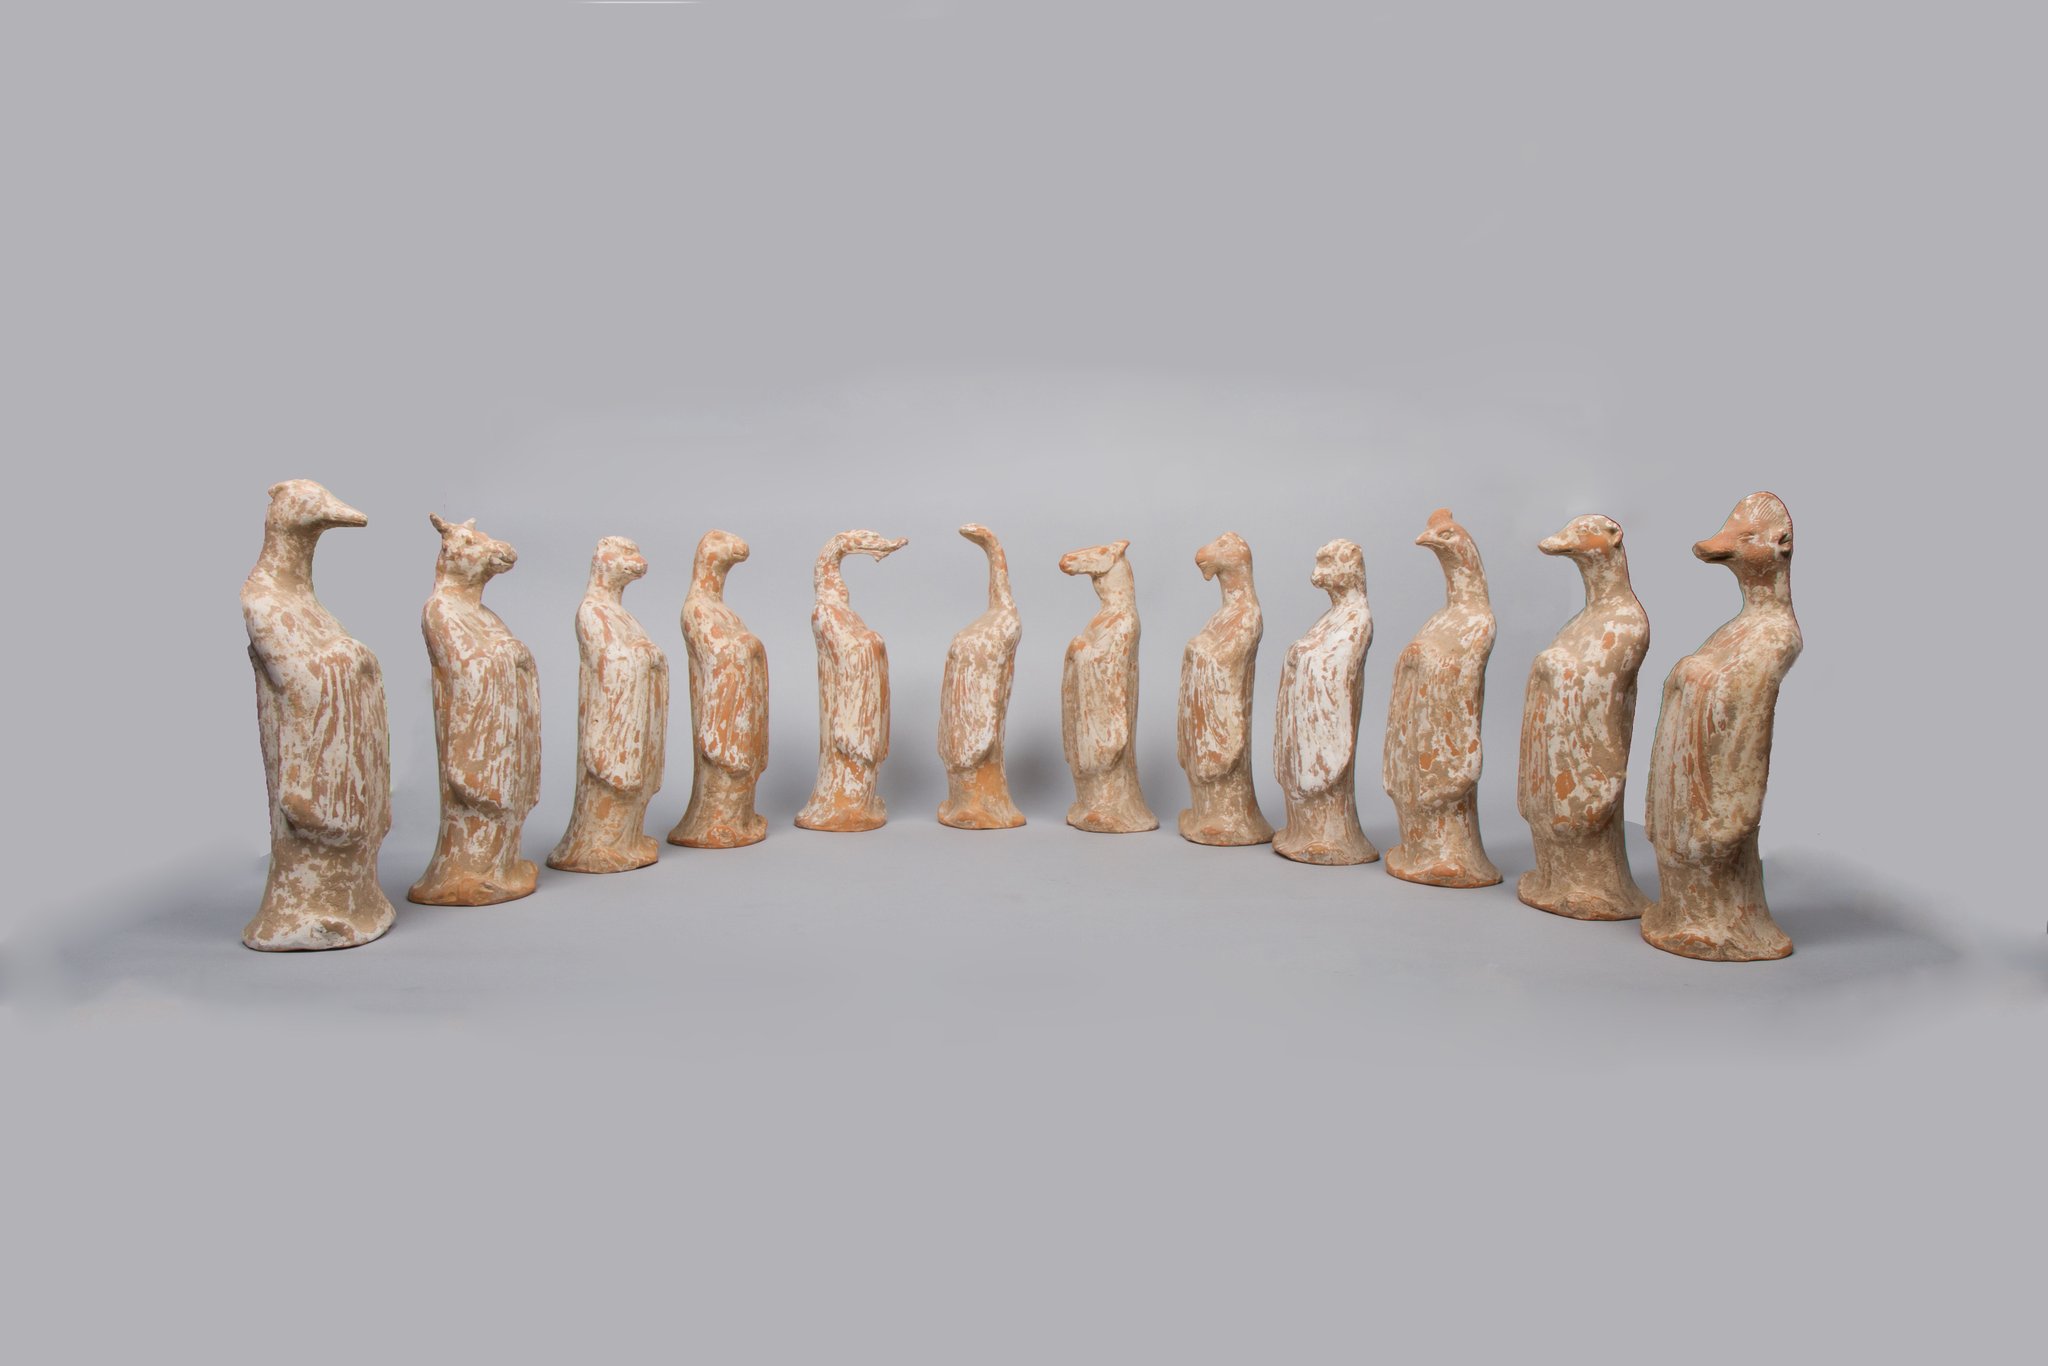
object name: figure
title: Set of twelve zodiac animals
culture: chinese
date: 701-800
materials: earthenware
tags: animals,dragons,roosters,dogs,goats,horses,monkeys,pigs,rabbits,rats,snakes,tigers,zodiac,ox